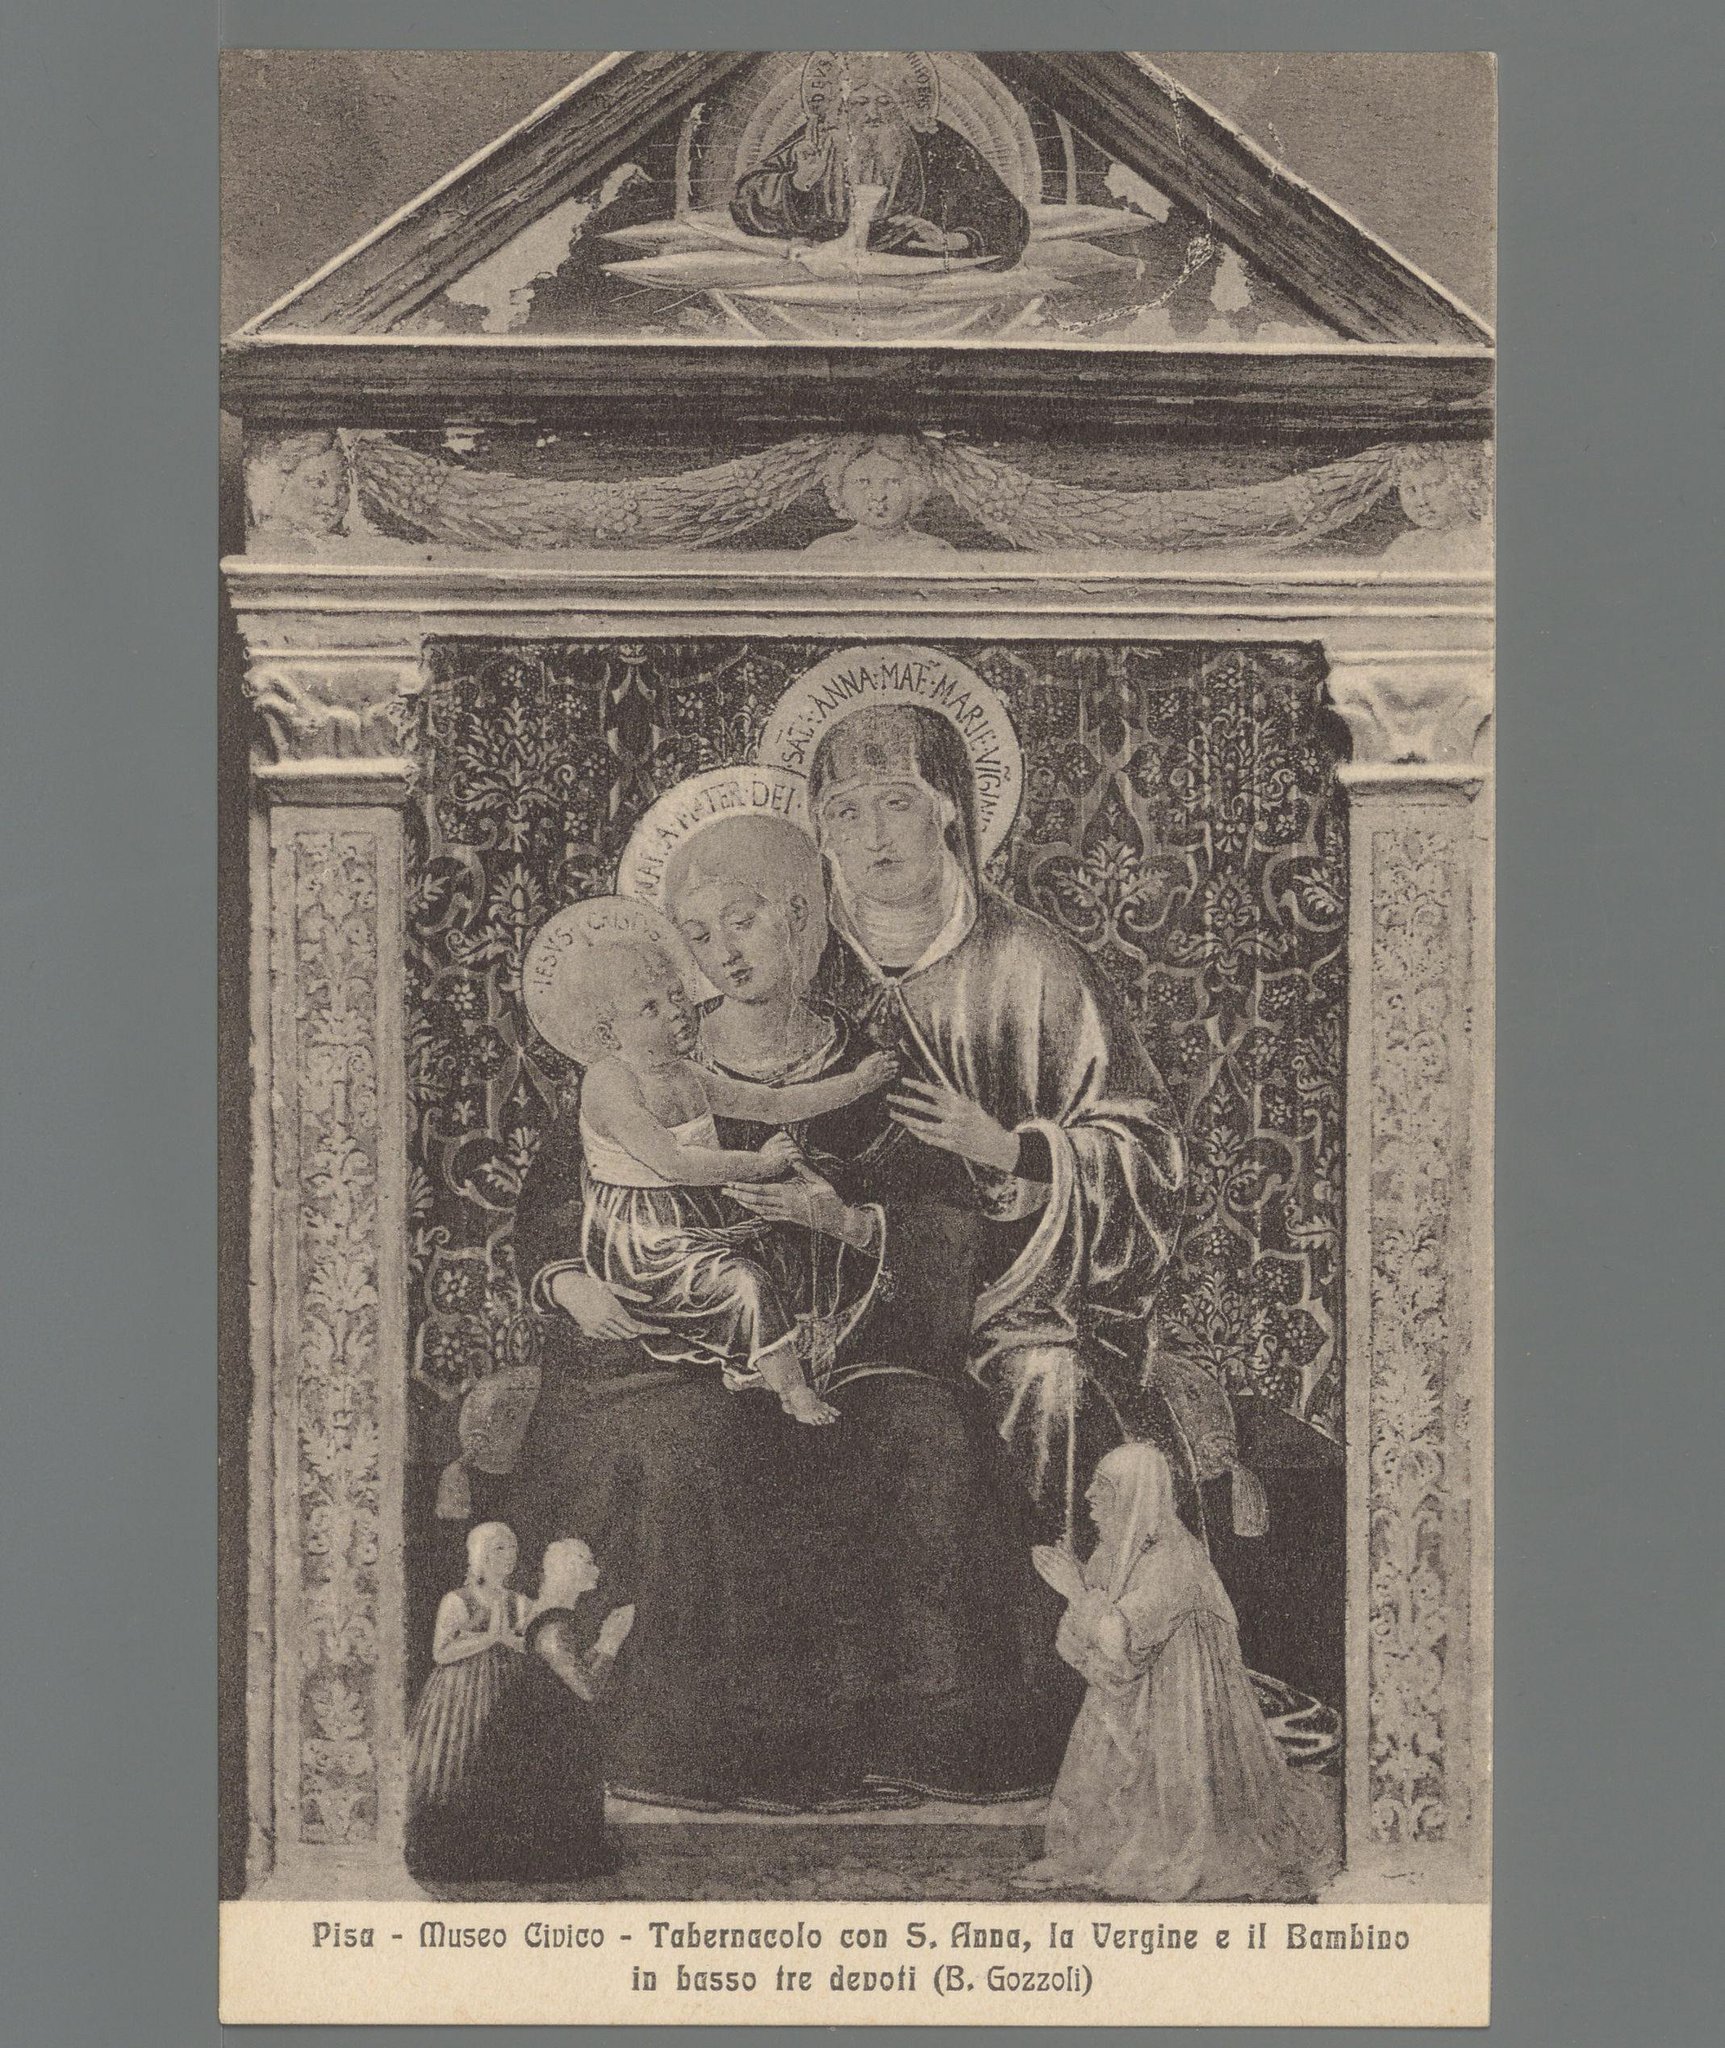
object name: reproduction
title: Pisa - Museo Civico - Tabernacolo con S. Anna, la Vergine e il Bambino in basso tre devoti (B. Gozzoli)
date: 1906-1930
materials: cardboard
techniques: photograph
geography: pisa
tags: interior of church, tabernacle ~ altar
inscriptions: collector's mark: ‘AFE v S’